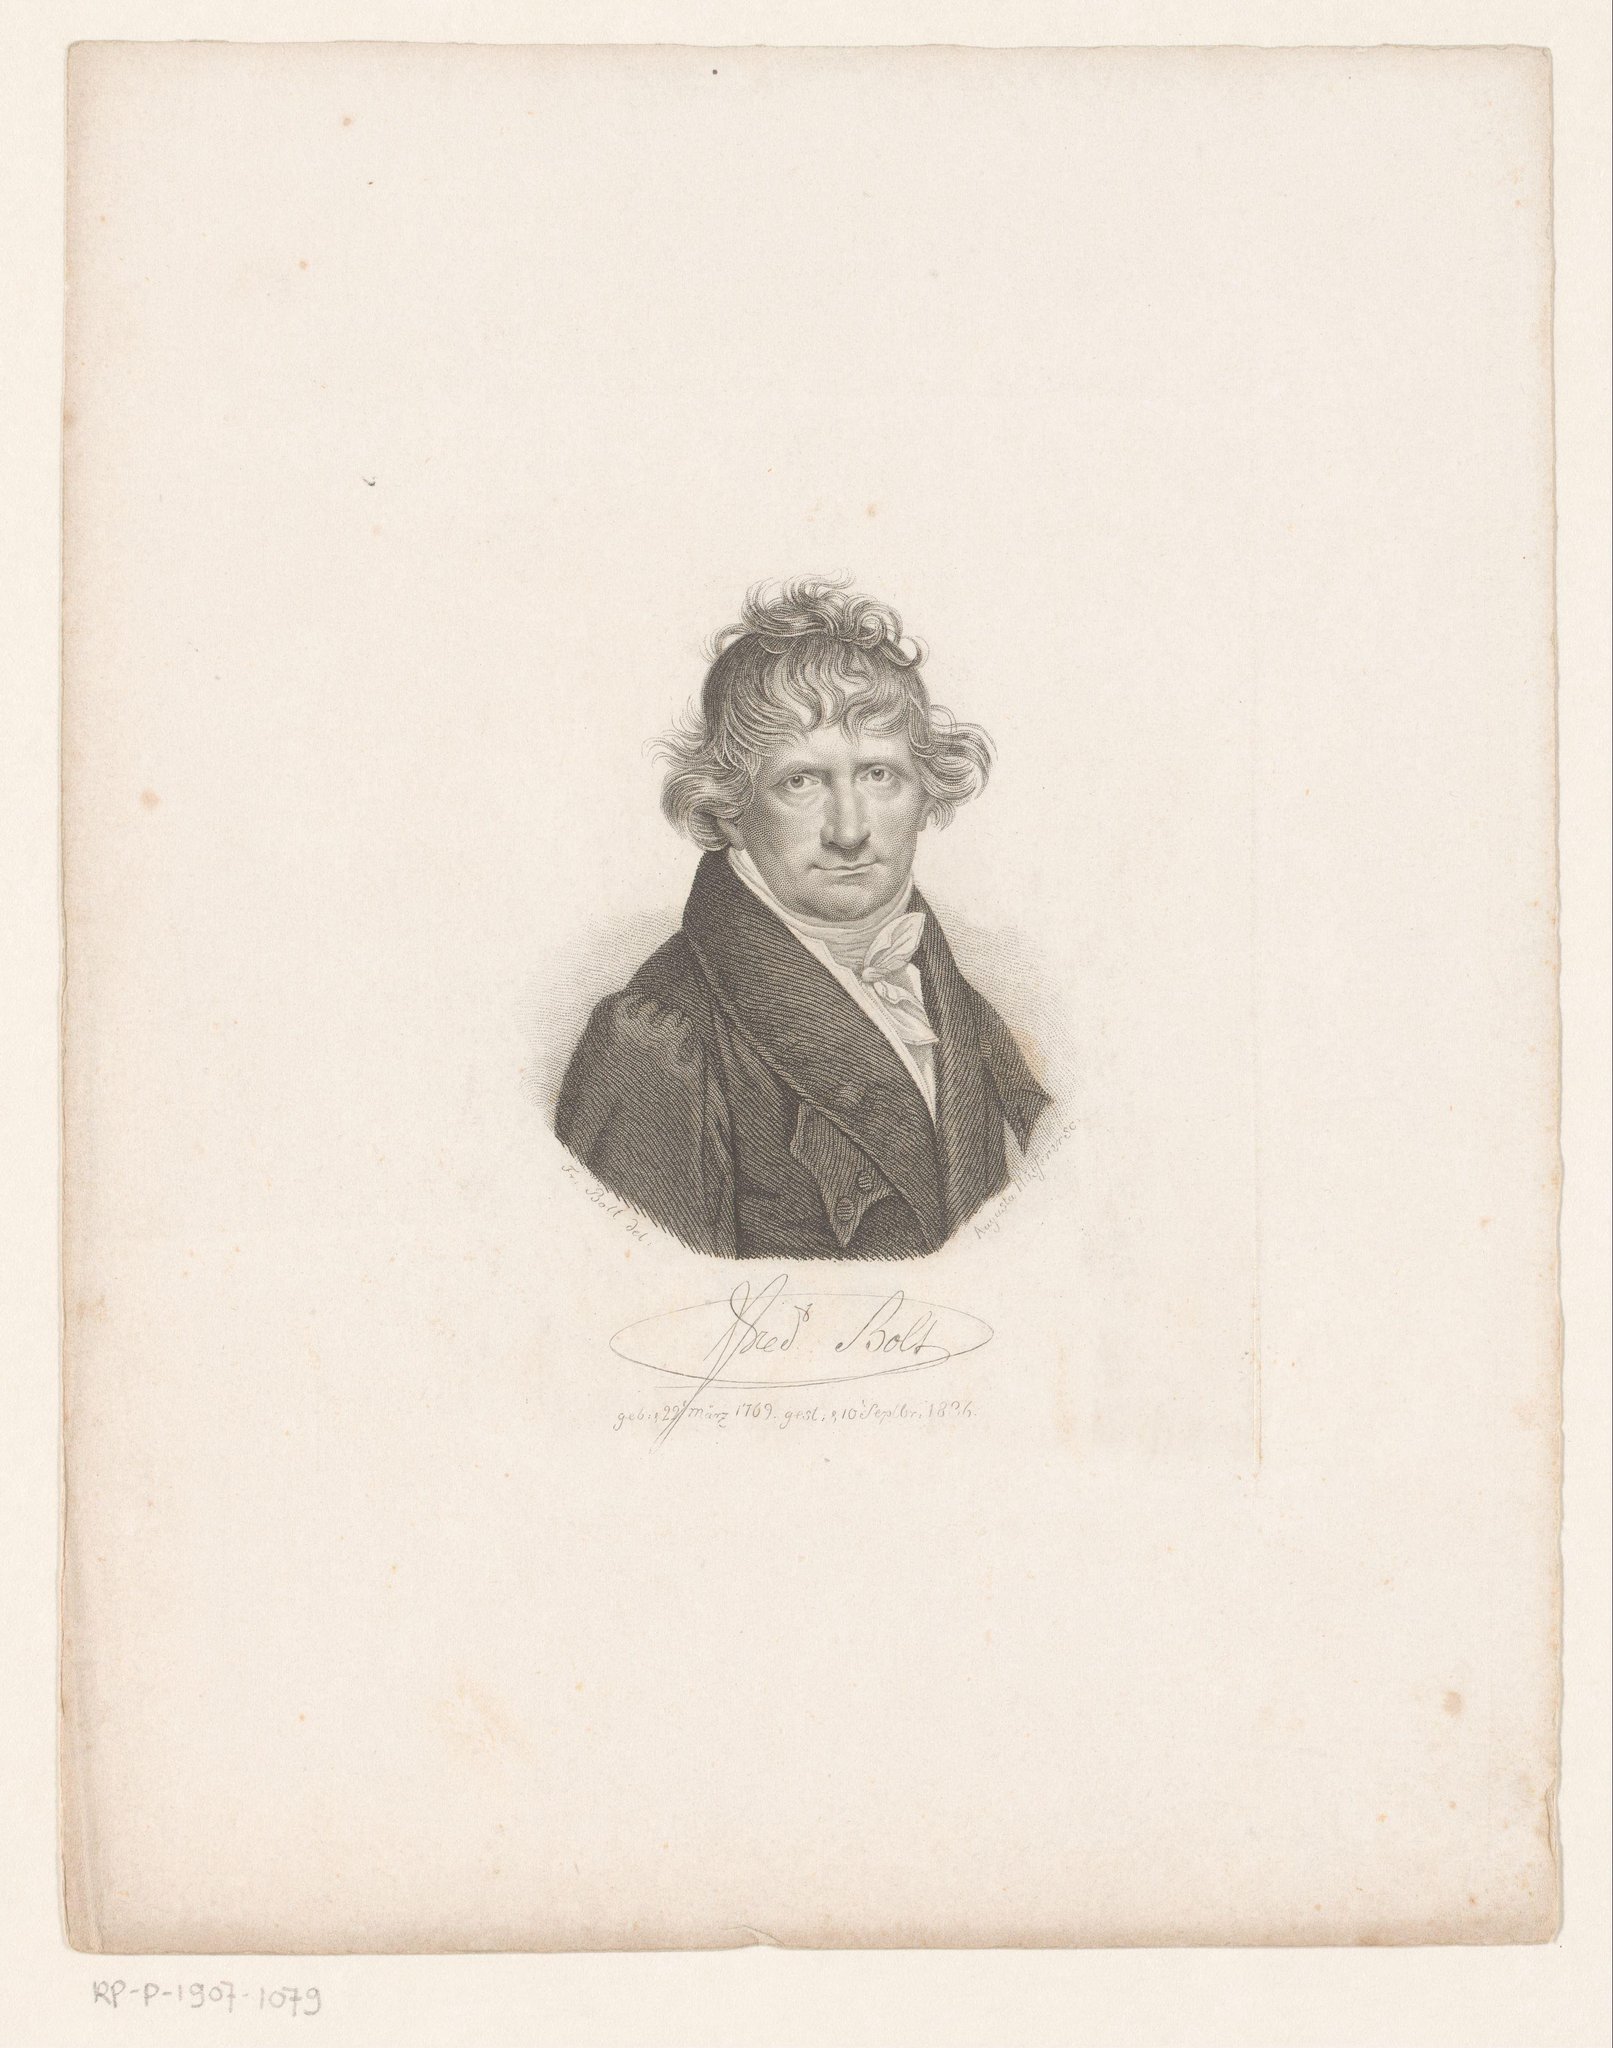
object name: print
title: Portret van Johann Friedrich Bolt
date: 1799-1877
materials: paper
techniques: stippling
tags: berlin, print maker, johann friedrich bolt, historical persons, portrait, self-portrait of graphic artist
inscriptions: collector's mark: Lugt 2228